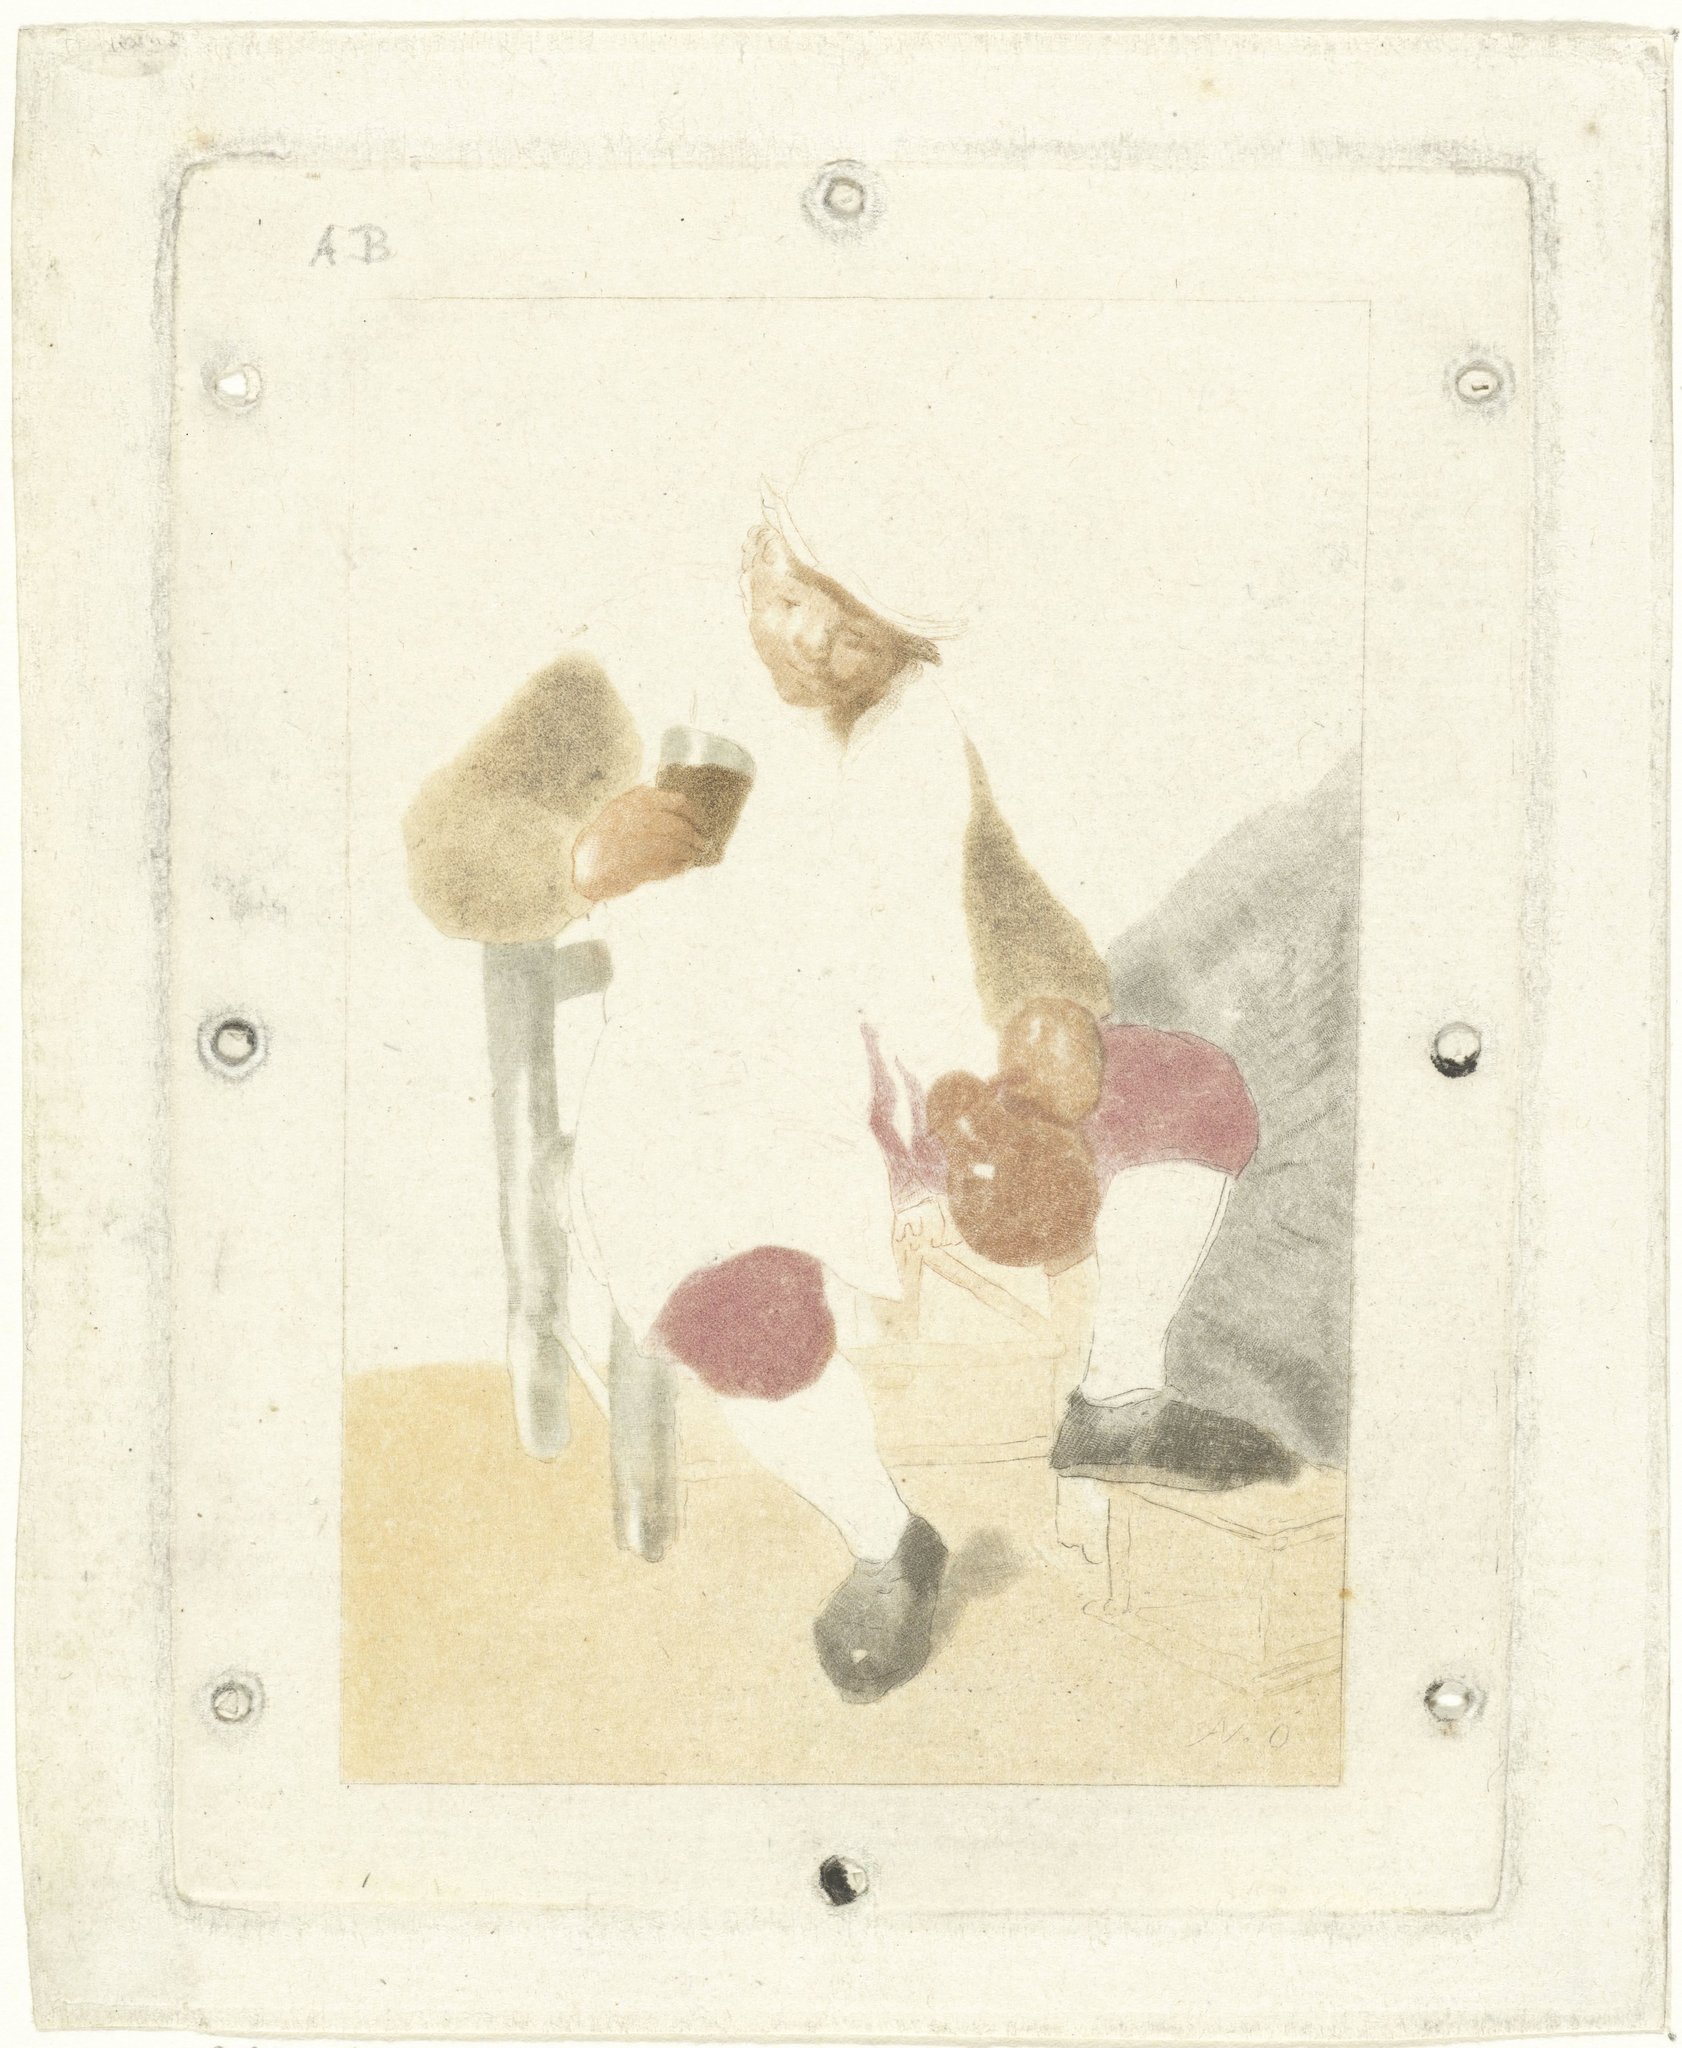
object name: print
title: Zittende boer met kruik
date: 1763-1768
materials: paper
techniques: roulette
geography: amsterdam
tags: sitting figure, jar, jug (used as drinking-vessel)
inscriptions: collector's mark: Lugt 2228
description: Voor deze prenttekening, 'Zittende boer met kruik', maakte Ploos van Amstel vier verschillende platen (A, B, C, en D). Er bestaan afdrukken van één, twee, drie of alle vier de platen in alle mogelijke combinaties. Zie gerelateerde objecten voor de hier gebruikte platen.